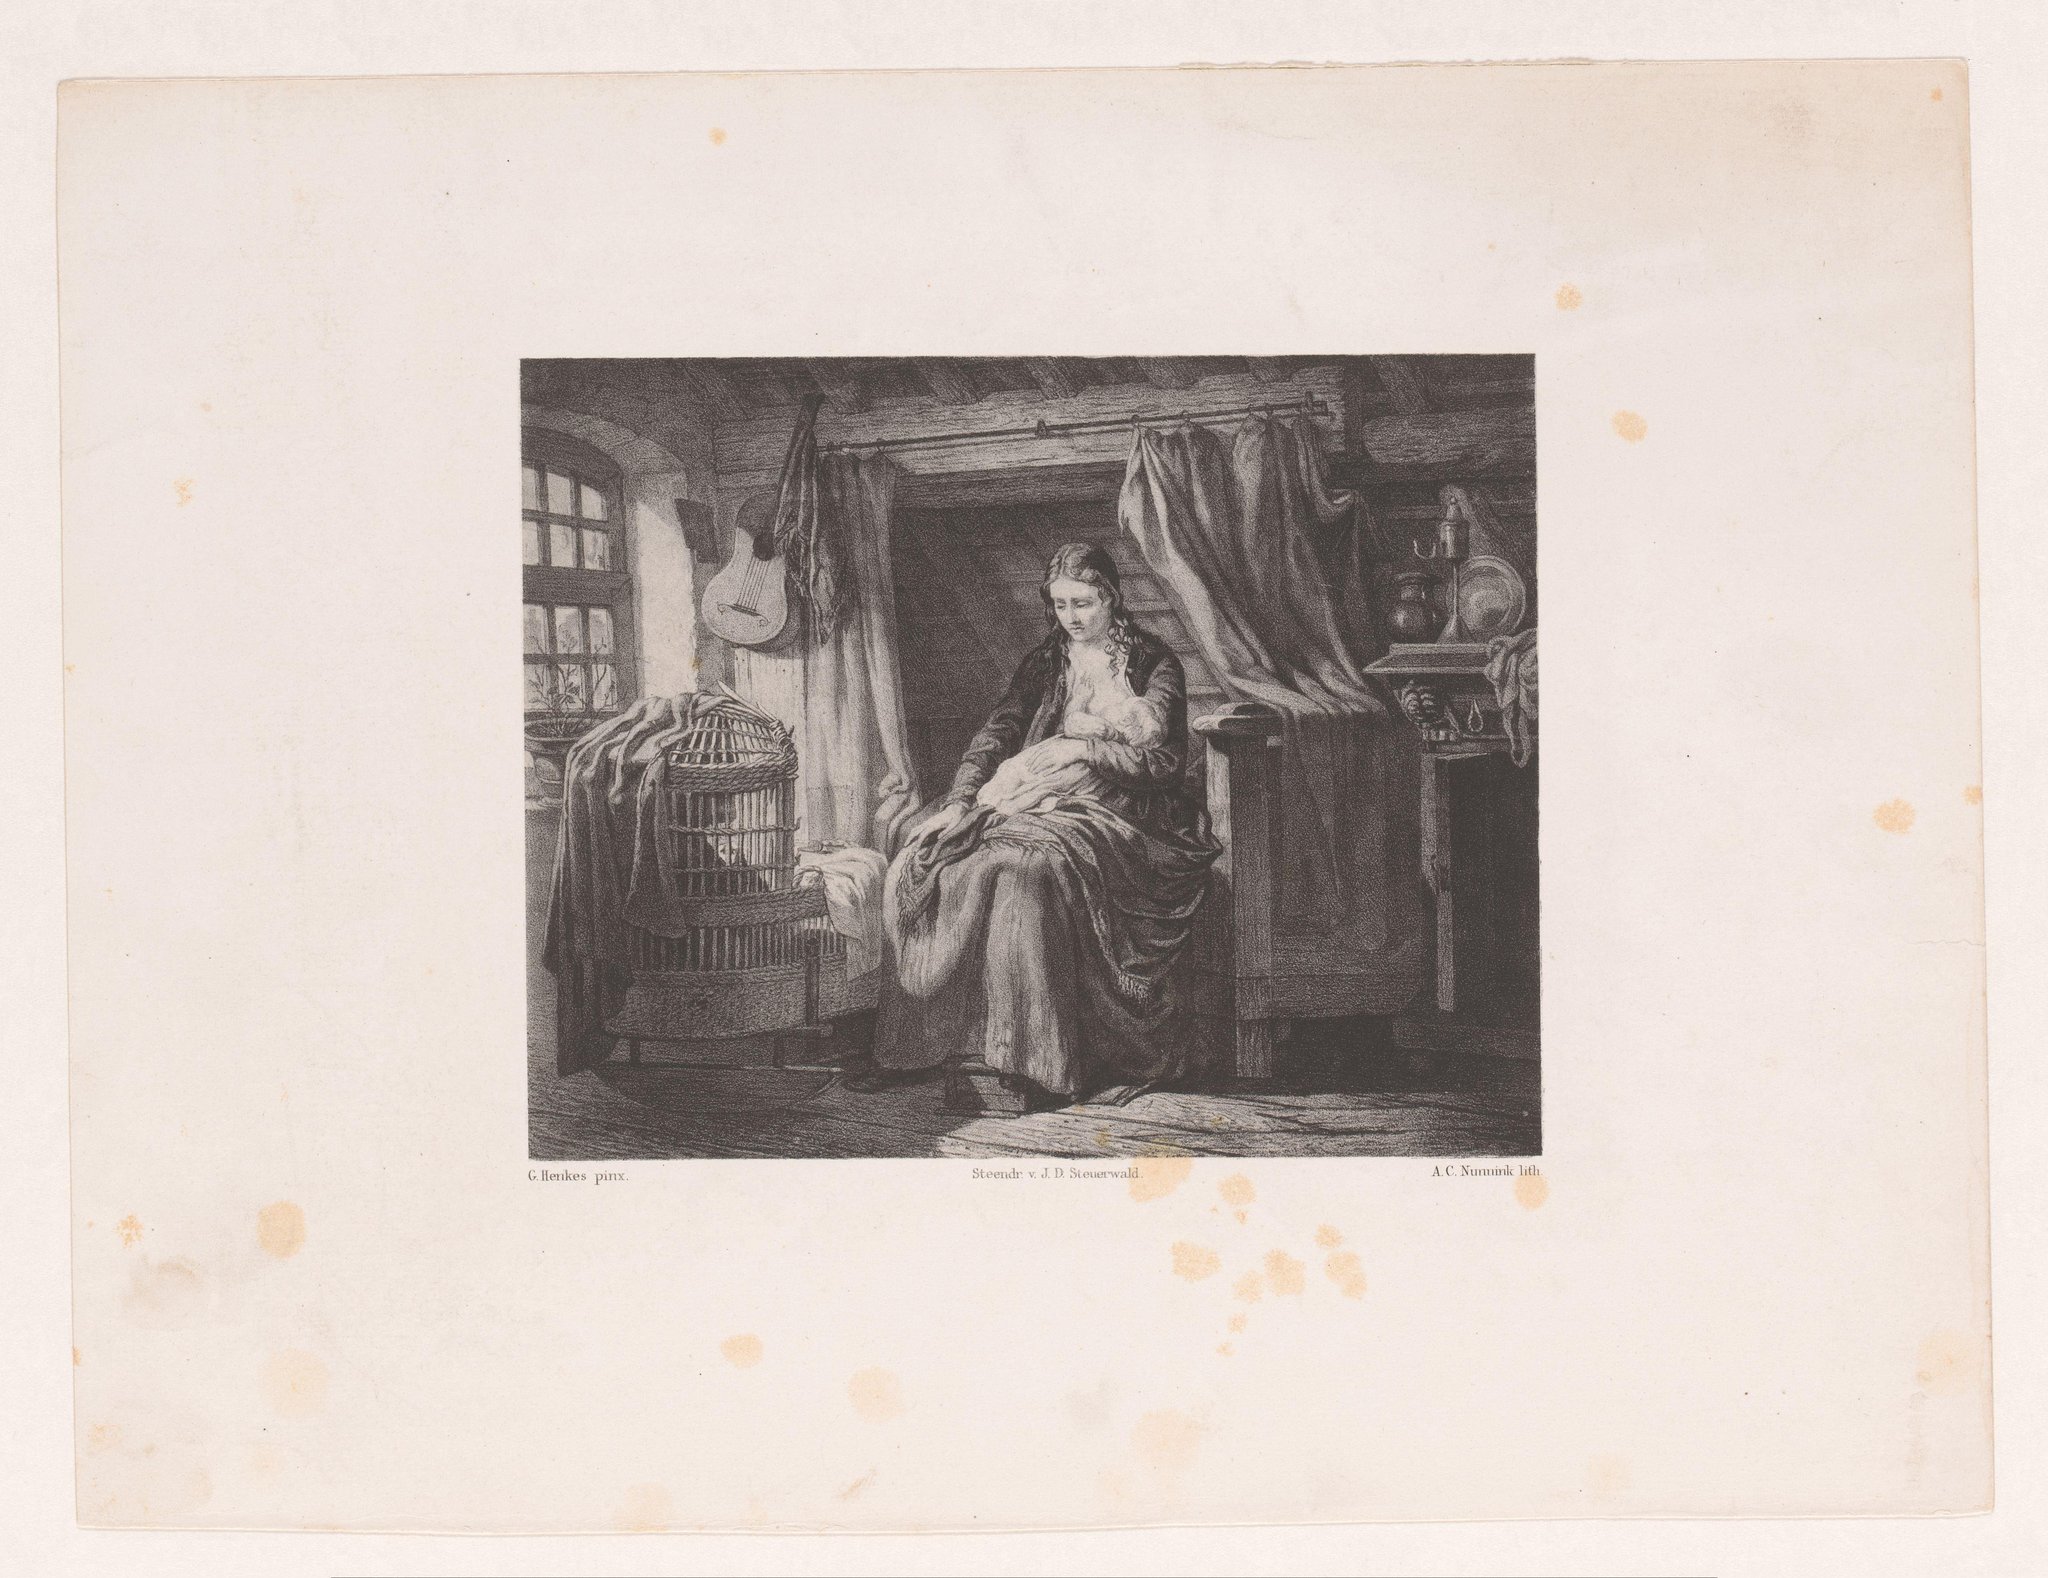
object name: print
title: Vrouw geeft kind de borst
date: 1854-1863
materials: paper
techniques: lithograph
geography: the hague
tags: feeding a baby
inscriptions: collector's mark: Lugt 2228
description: Een vrouw in een interieur zit op bed en geeft haar kind de borst. Links staat de wieg van het kind.